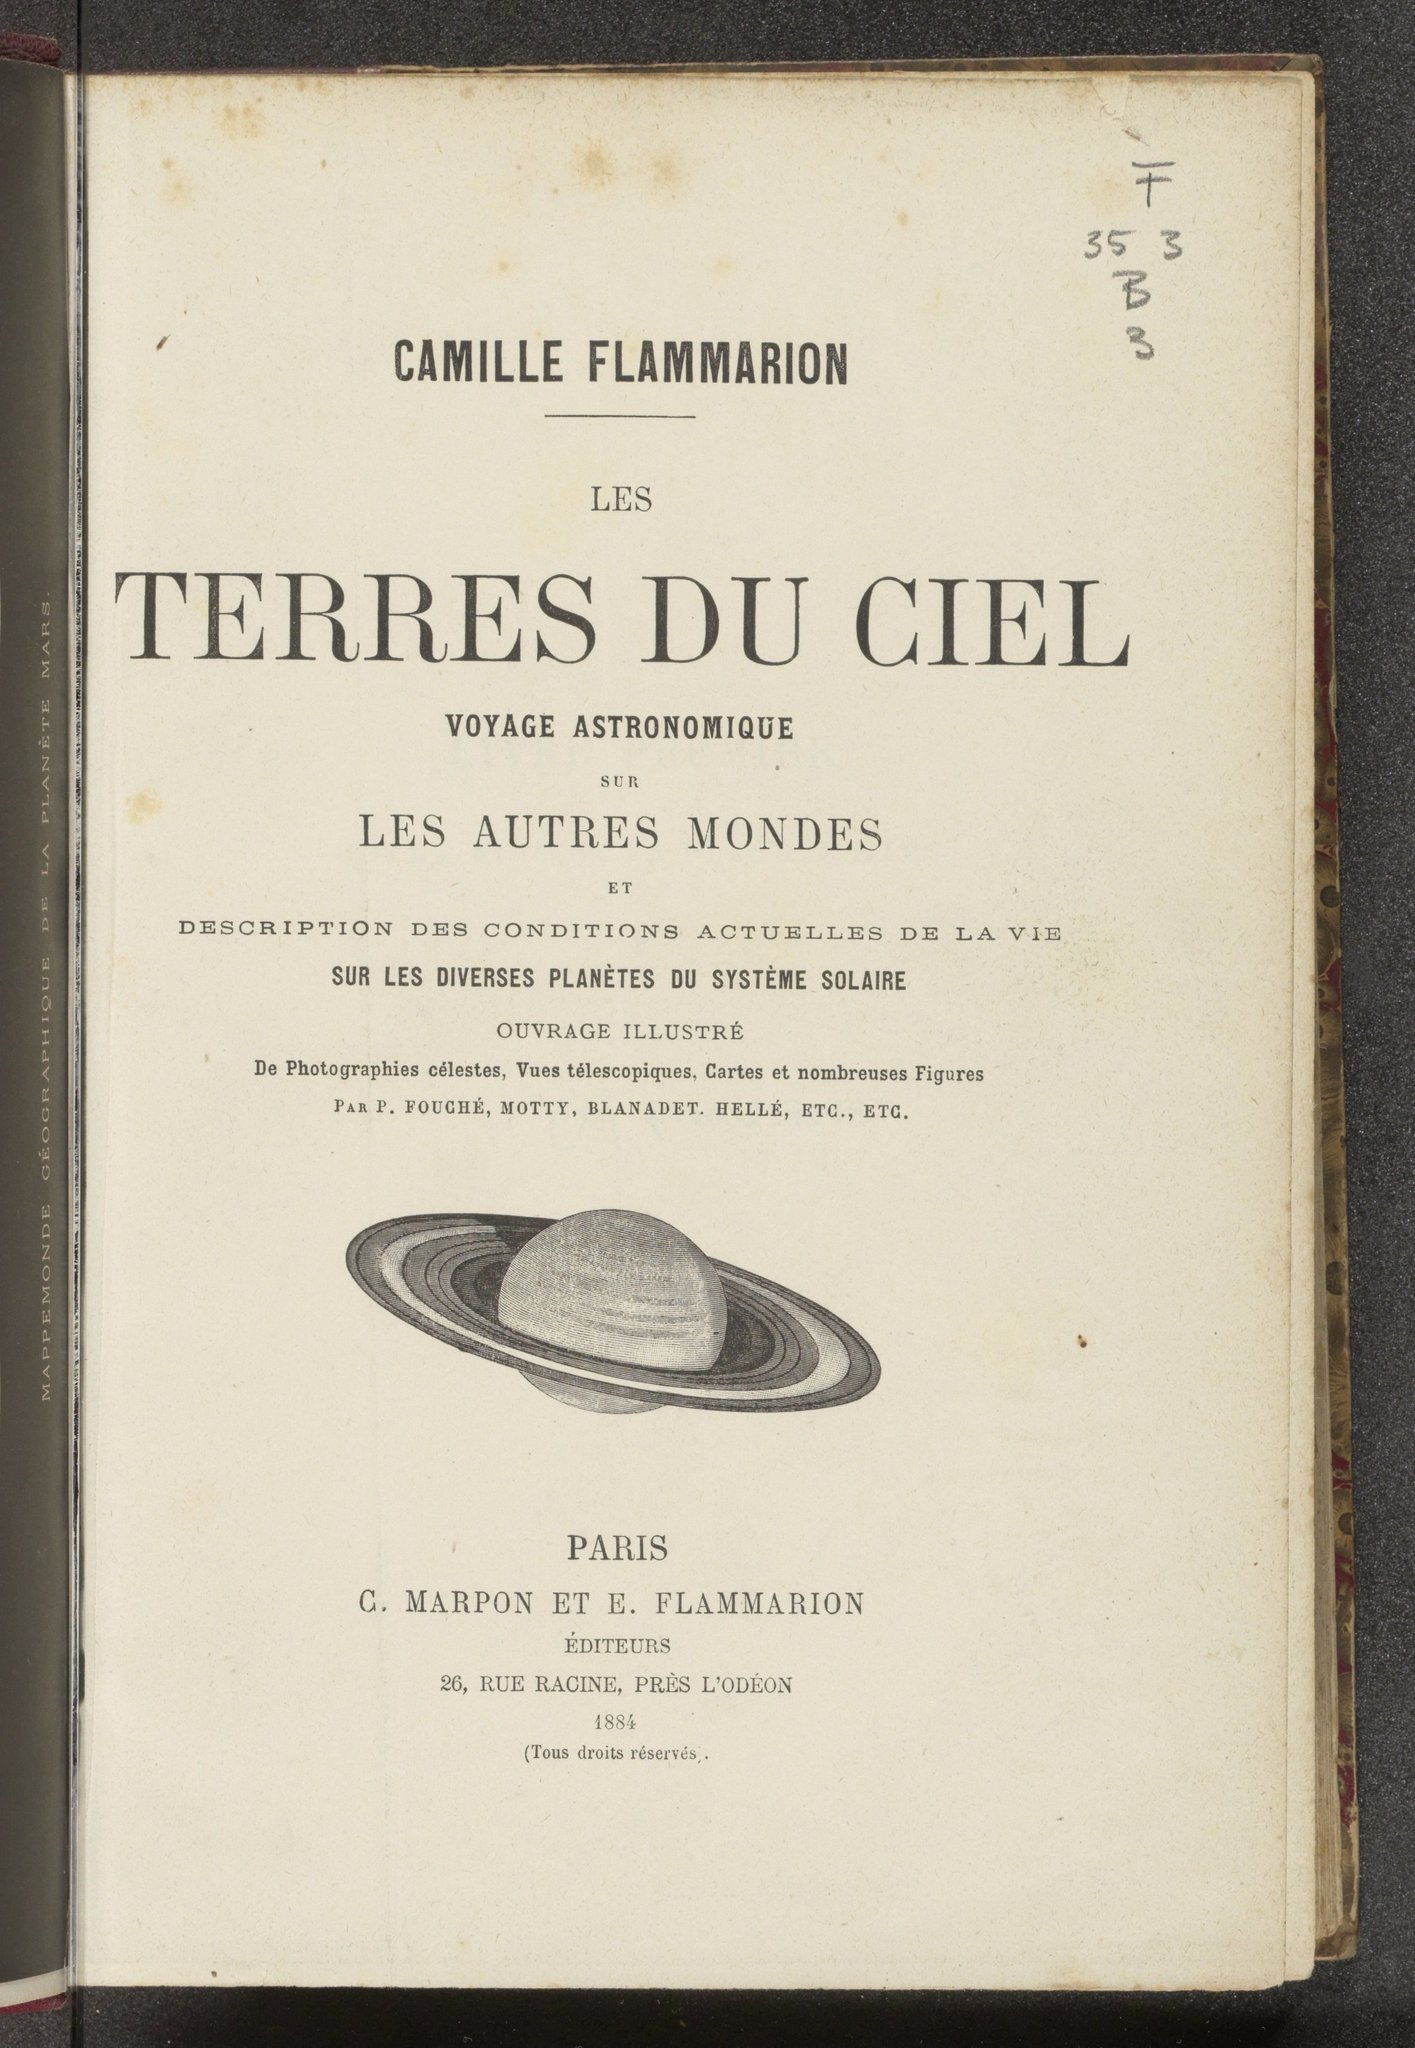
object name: book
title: Les terres du ciel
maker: camille flammarion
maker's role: astronoom, schrijver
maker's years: 1842-1925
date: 1884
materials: cardboard, linen, paper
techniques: photograph, engraving, lithograph, printing, marbled paper, marbling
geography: paris